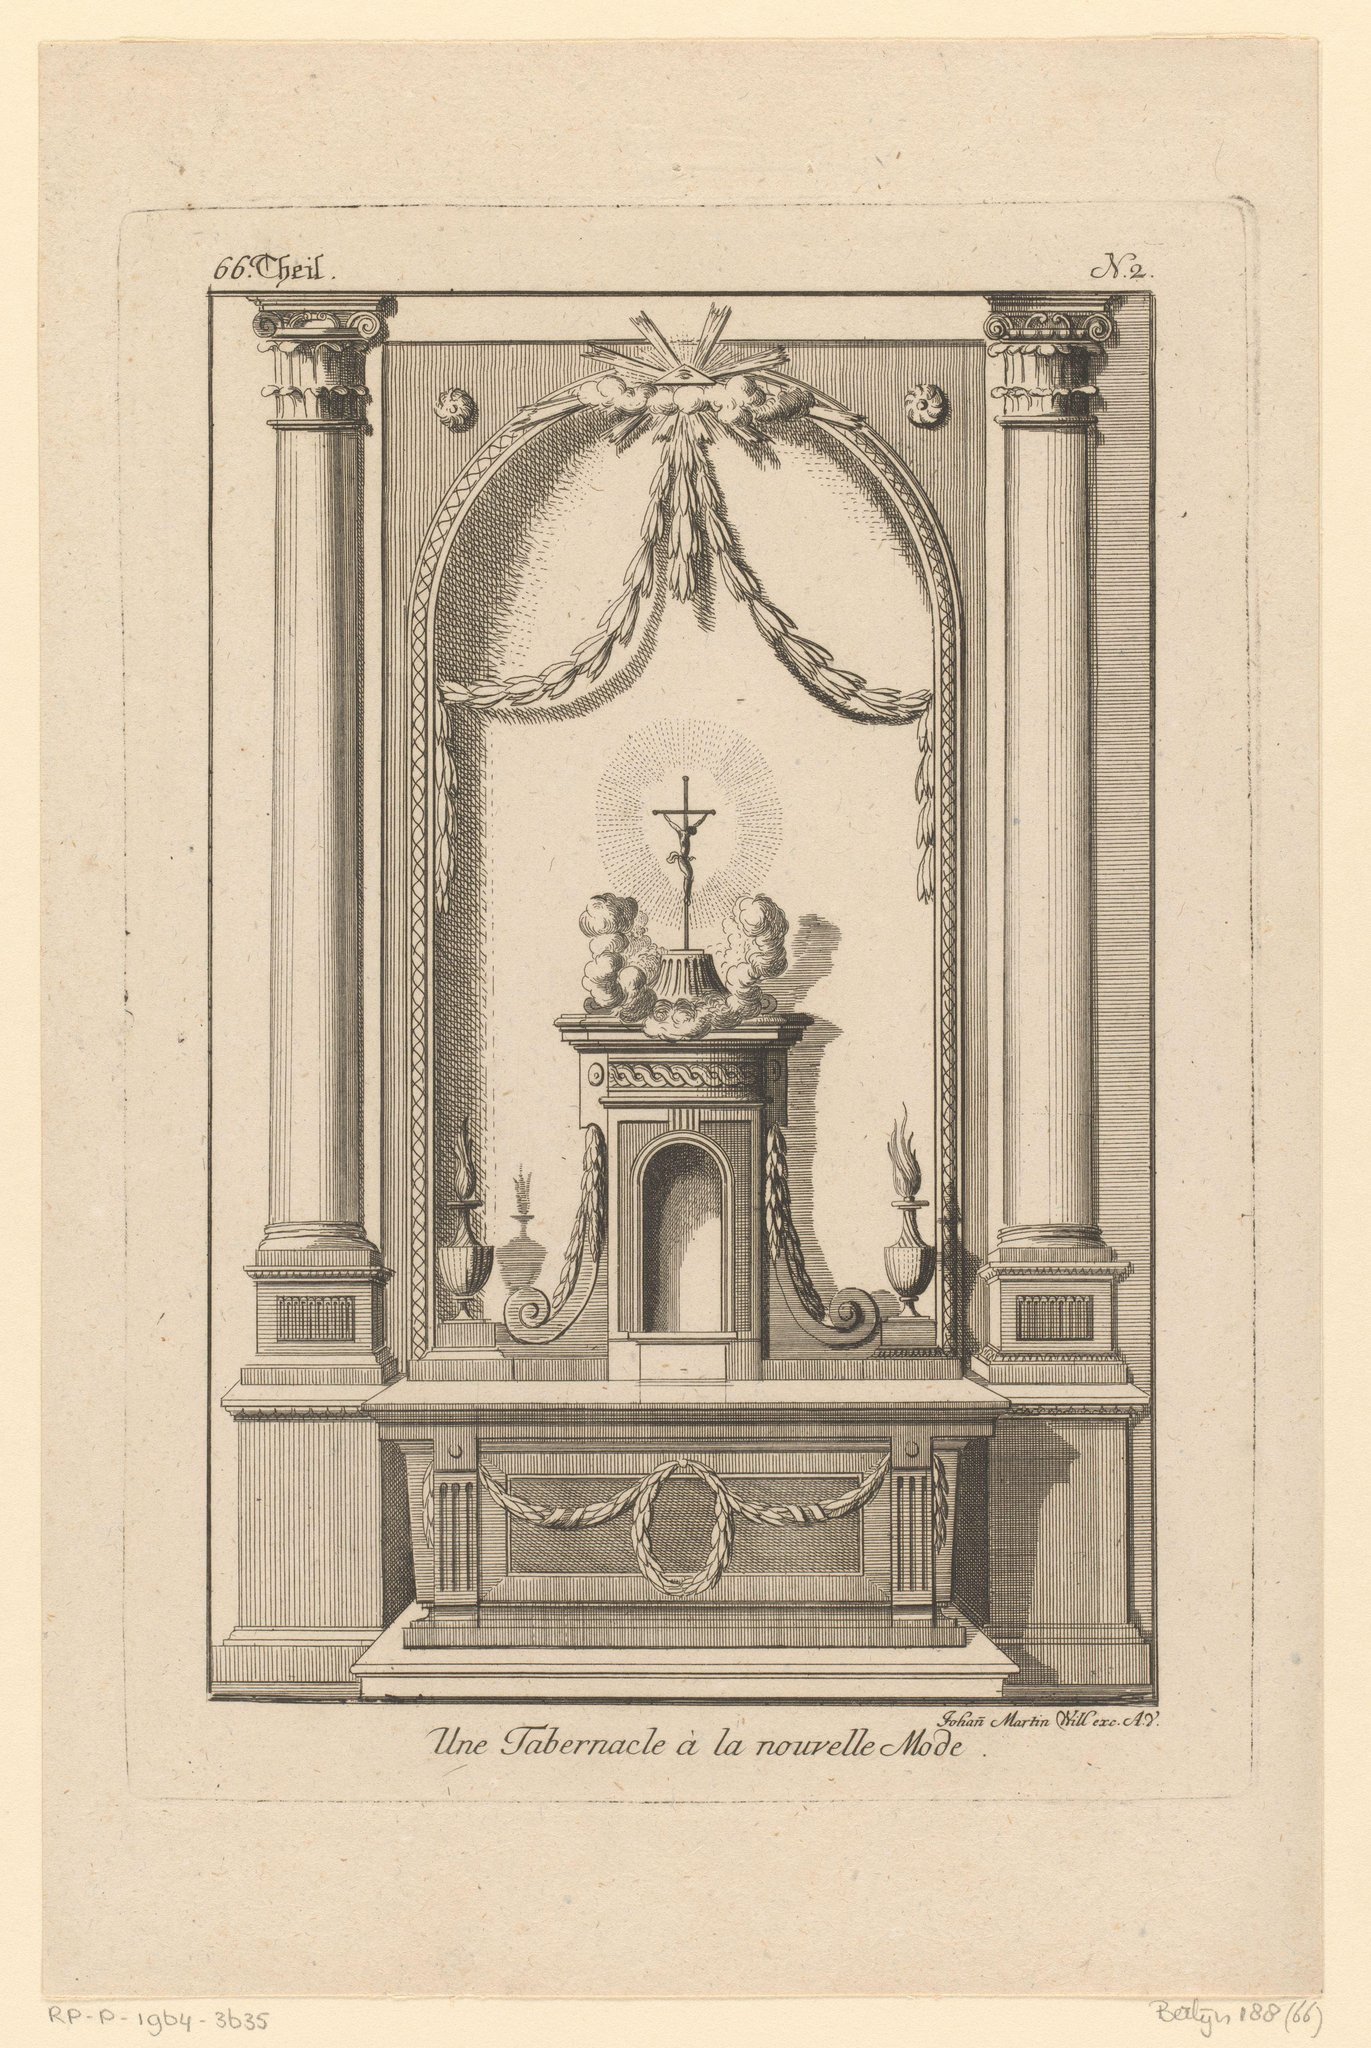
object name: print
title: 66. Theil. Une Tabernacle à la nouvelle Mode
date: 1737-1806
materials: paper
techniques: engraving, etching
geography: augsburg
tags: altarcross, crucifix, vase ~ ornament, tabernacle ~ altar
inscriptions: collector's mark: Lugt 2760, collector's mark: Lugt 2228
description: Een tabernakel in een nis met zuilen. Op het tabernakel staat een kruisbeeld omgeven door wolken en een stralenkrans, aan weerszijden staat een vaas.